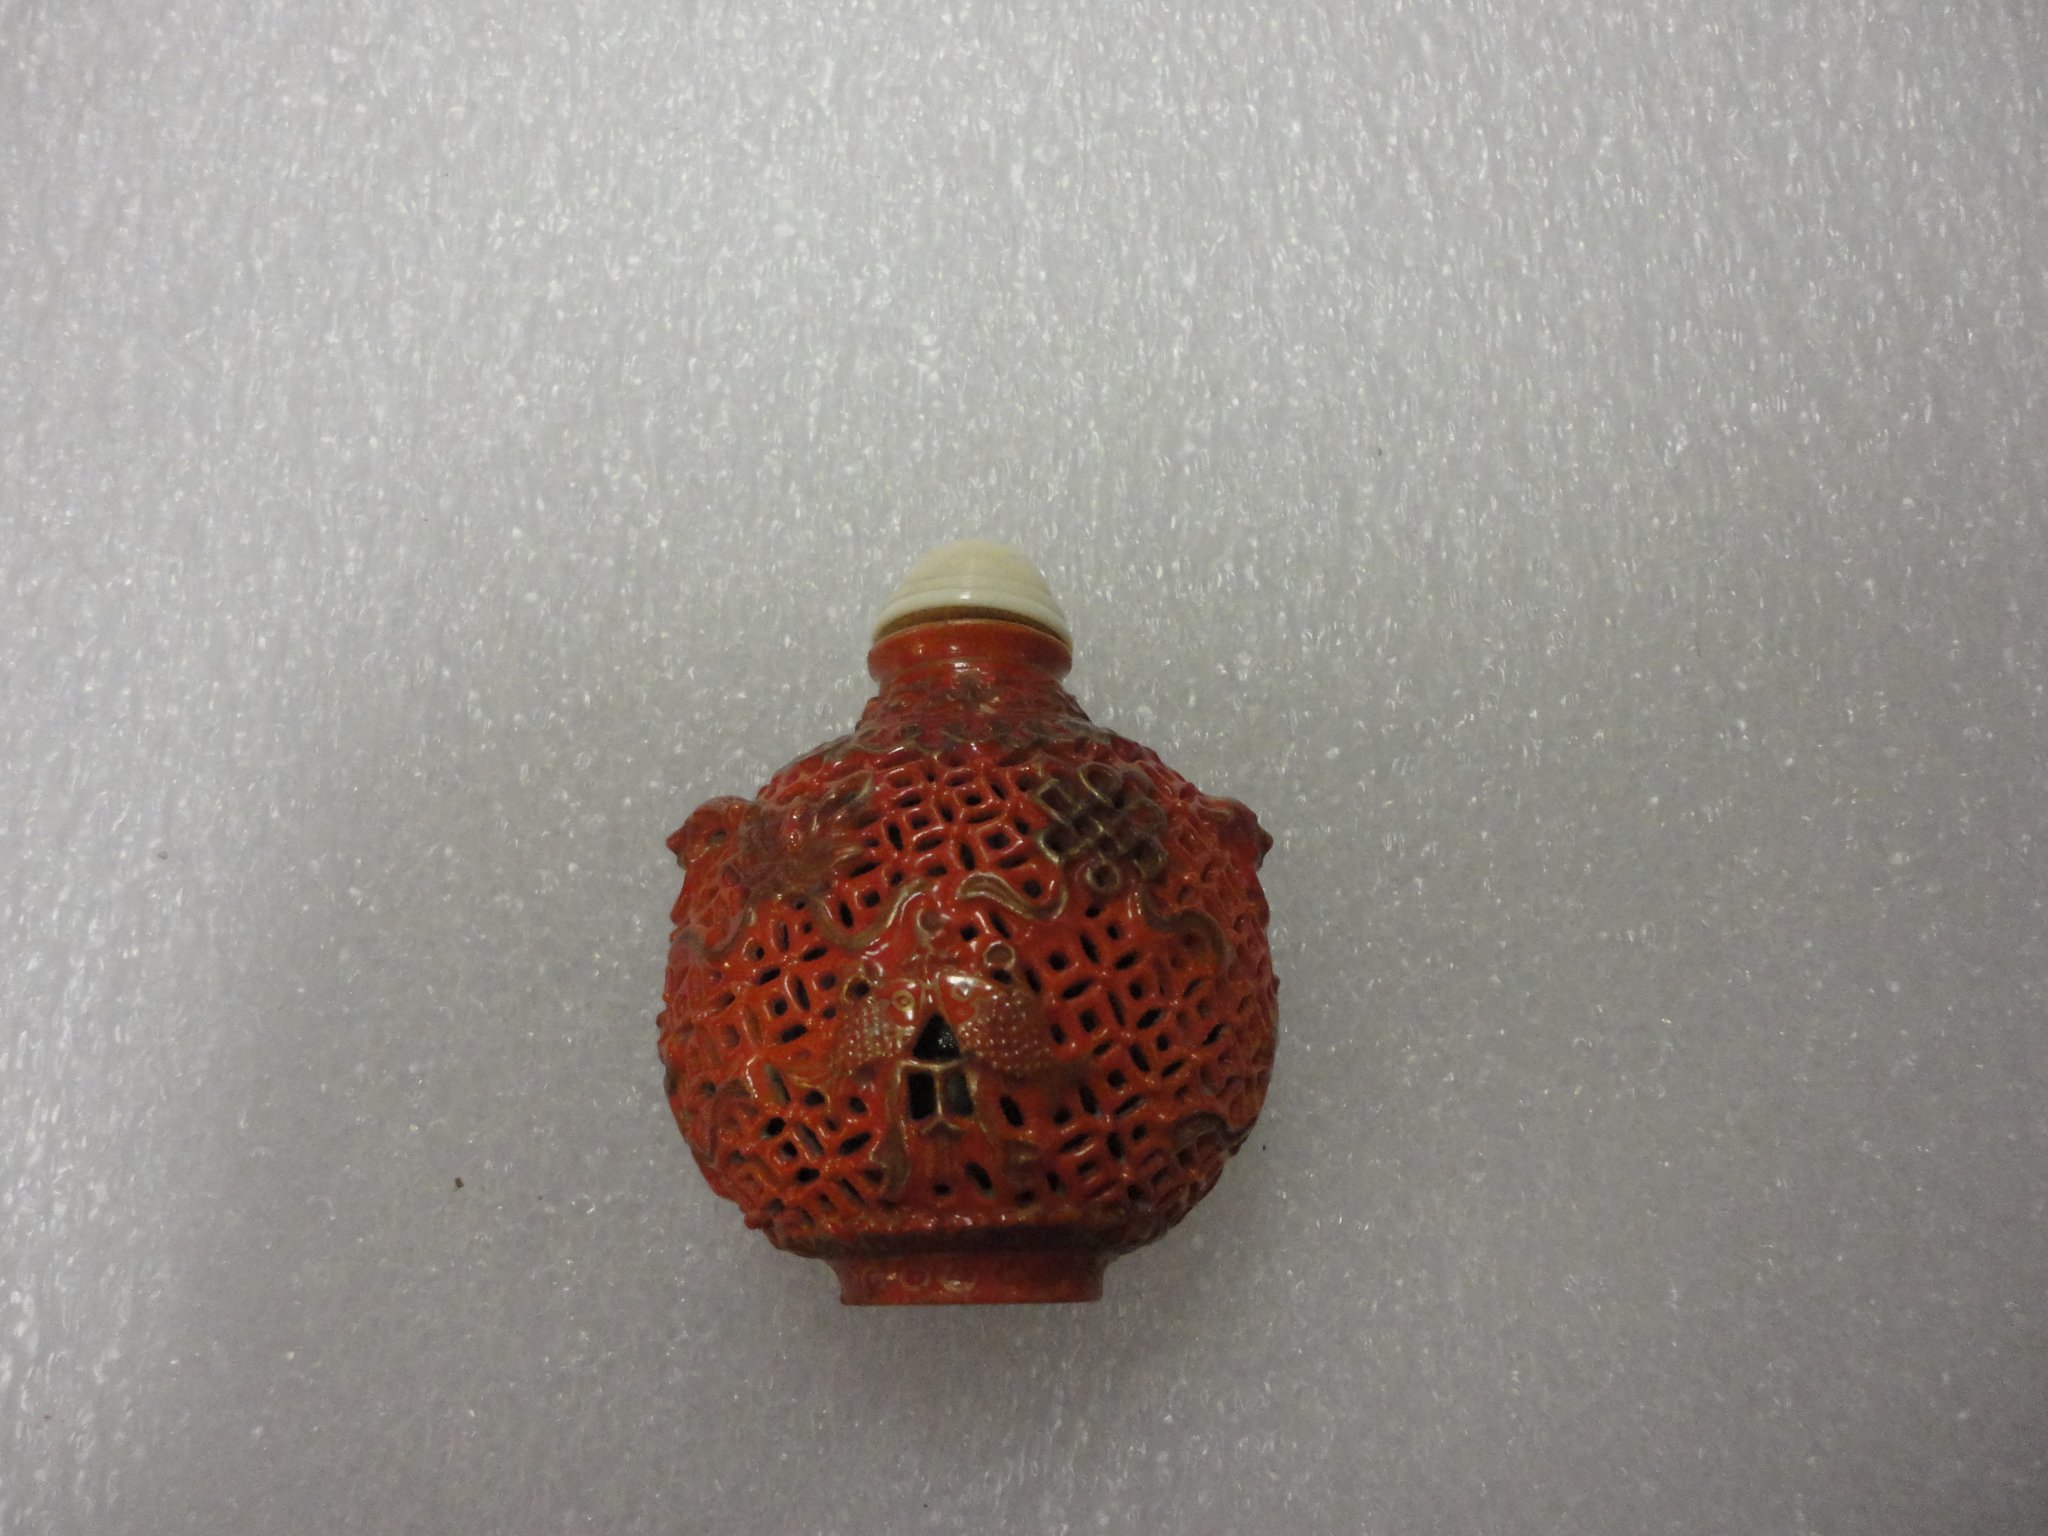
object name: snuff bottle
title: Snuff bottle with eight Buddhist treasures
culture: chinese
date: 1801-1833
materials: enamel, gold, porcelain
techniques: overglaze, painting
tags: fish